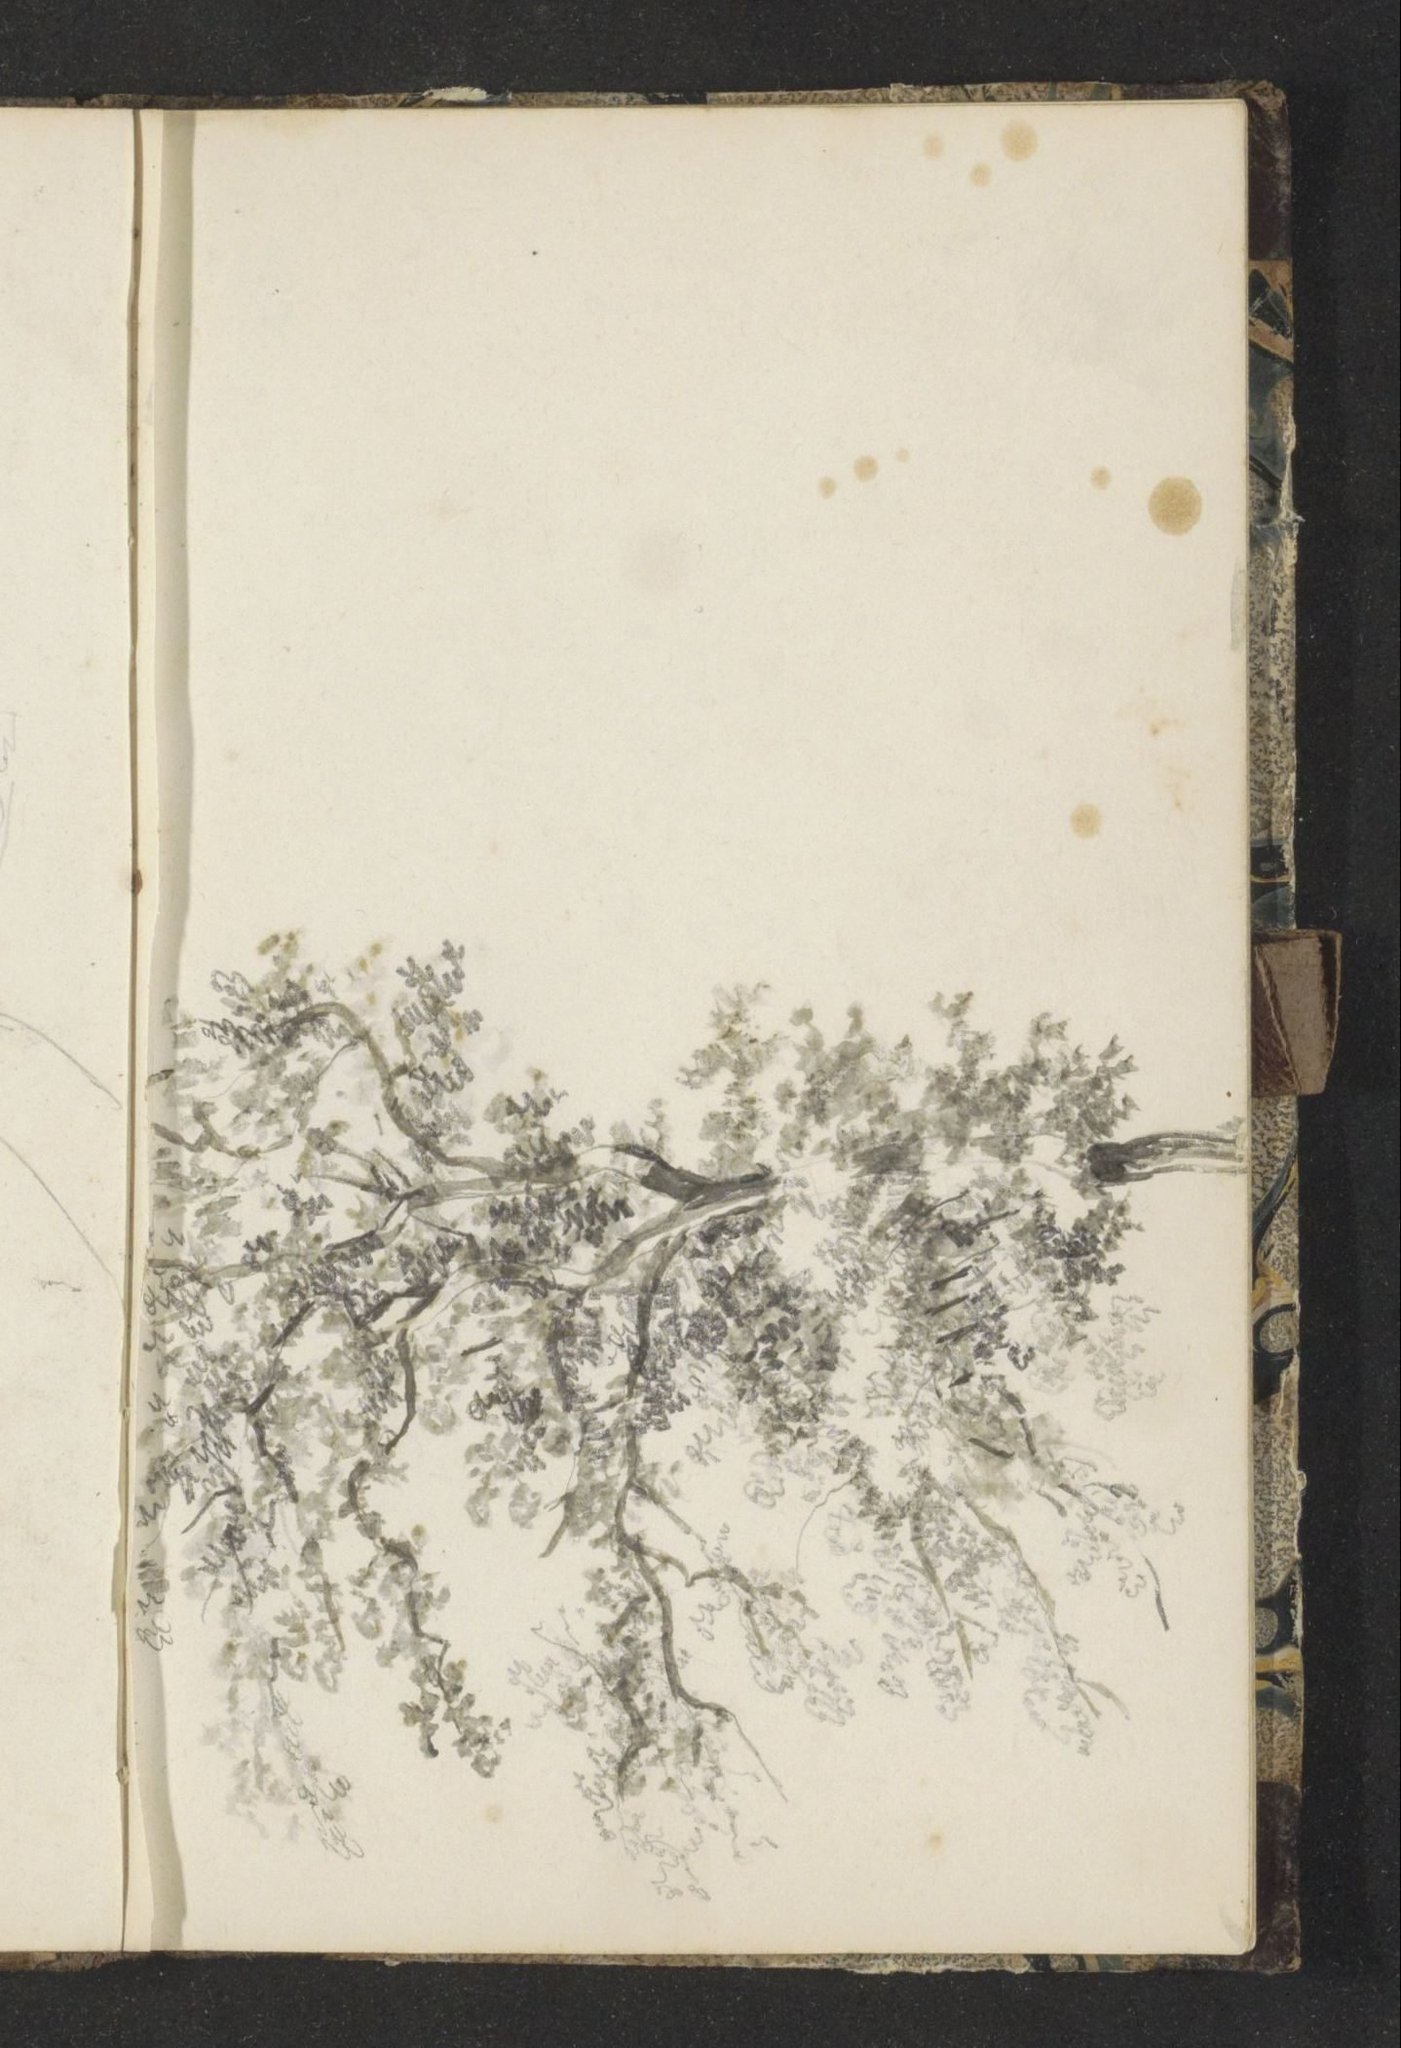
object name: sketchbook leaf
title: Boom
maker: Anonymous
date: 1802-1874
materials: paper, pencil, watercolor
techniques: brush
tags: trees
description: Blad 4 recto uit een schetsboek met 19 bladen.